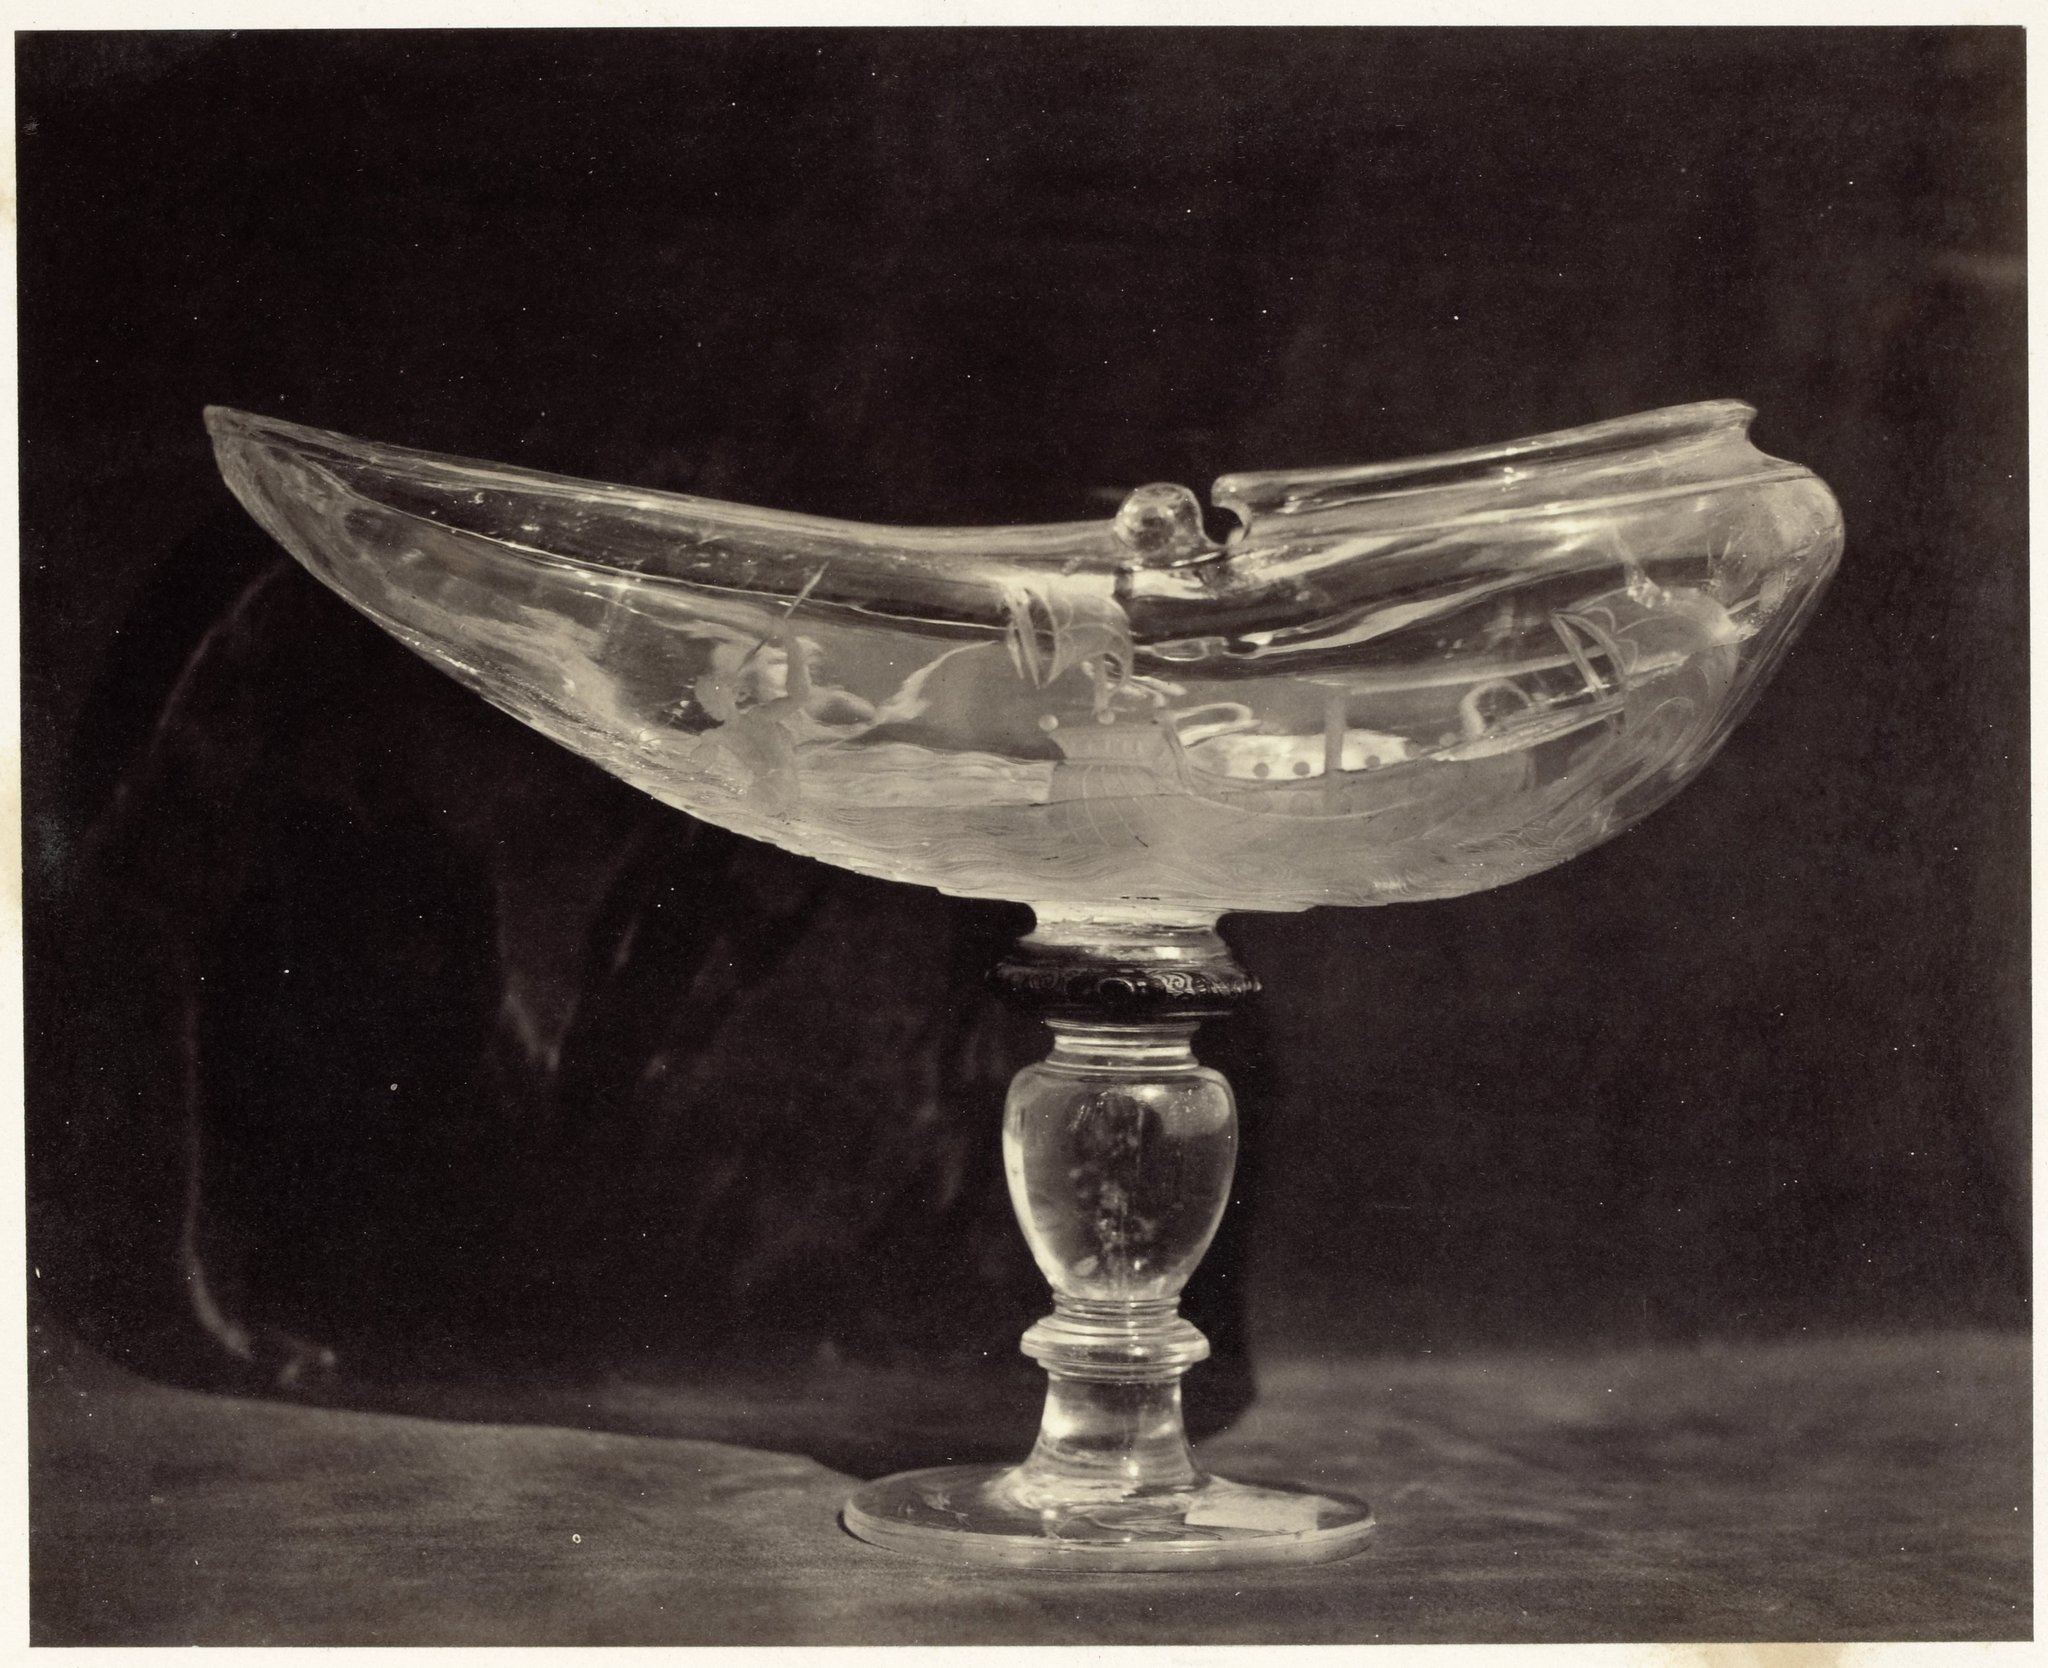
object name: photomechanical print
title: Kristallen schelpvormige schaal op voet, uit het Louvre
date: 1866-1890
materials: paper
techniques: woodburytype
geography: louvre museum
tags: container of glass: bottle, jar, vase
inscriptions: inscription: ‘Photographed by C. Thurston Thompson.’